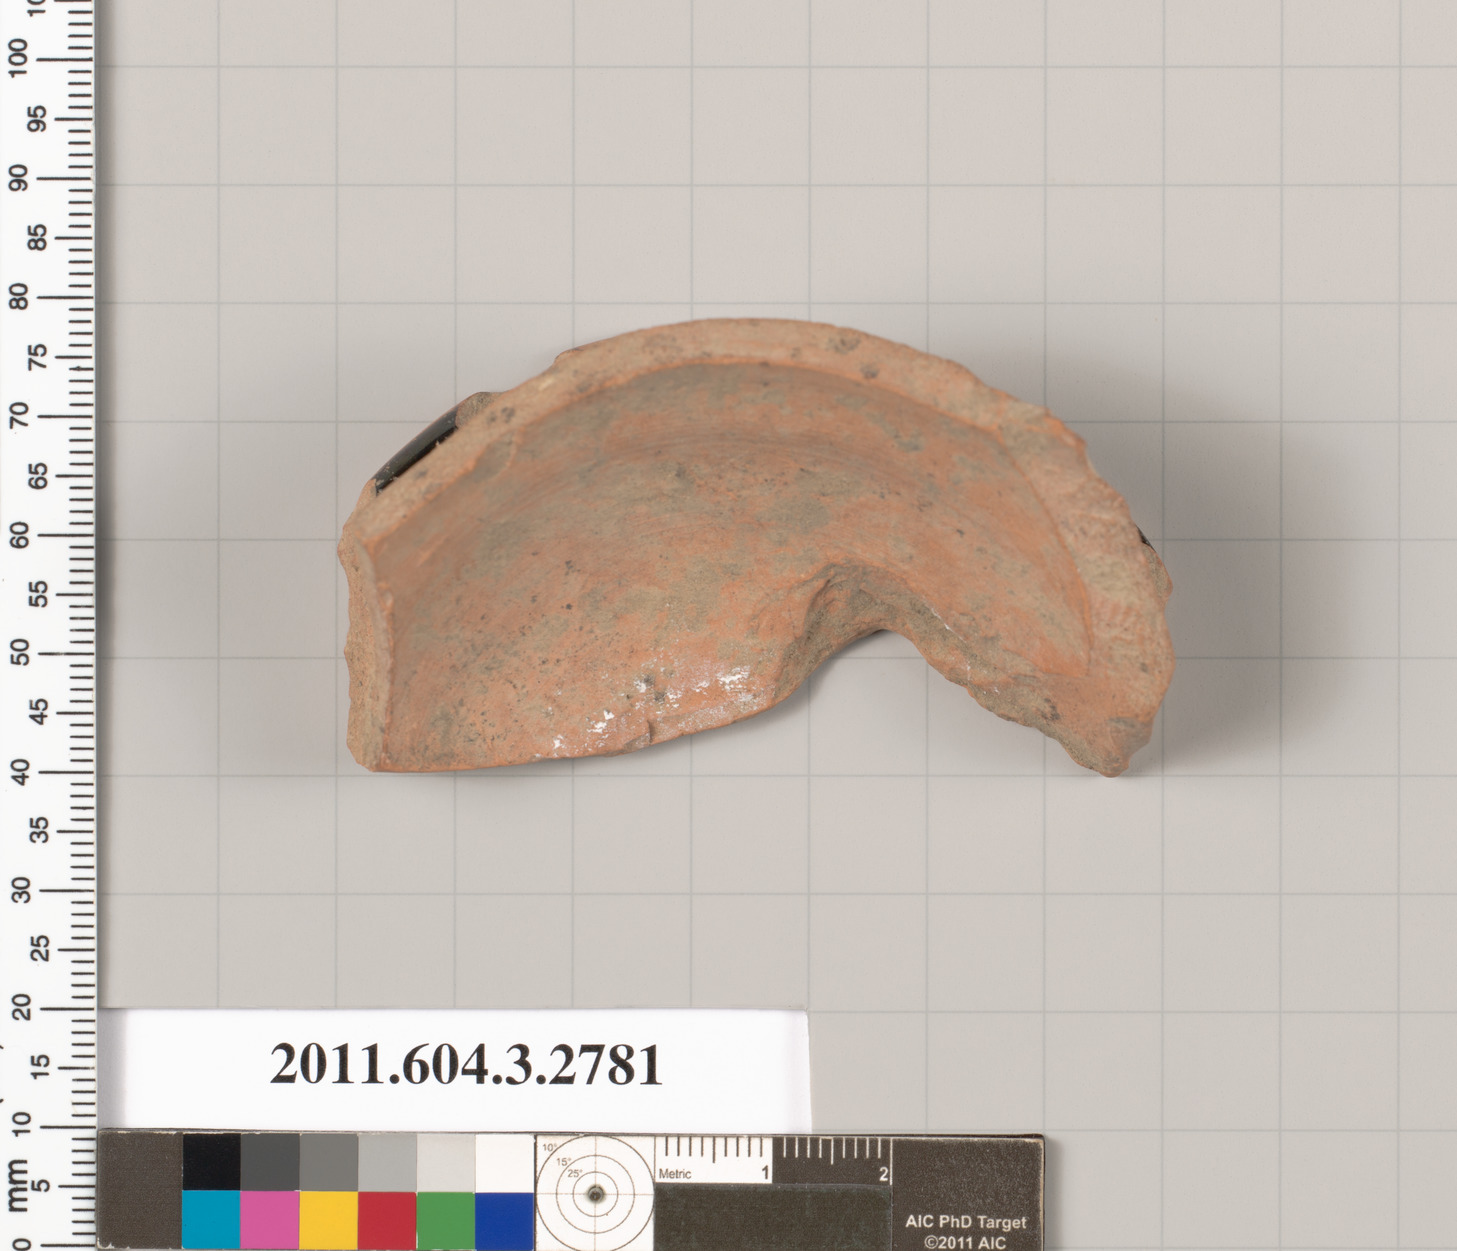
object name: olpe fragment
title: Terracotta fragment of an olpe (jug)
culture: greek, attic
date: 525-501 BCE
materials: terracotta